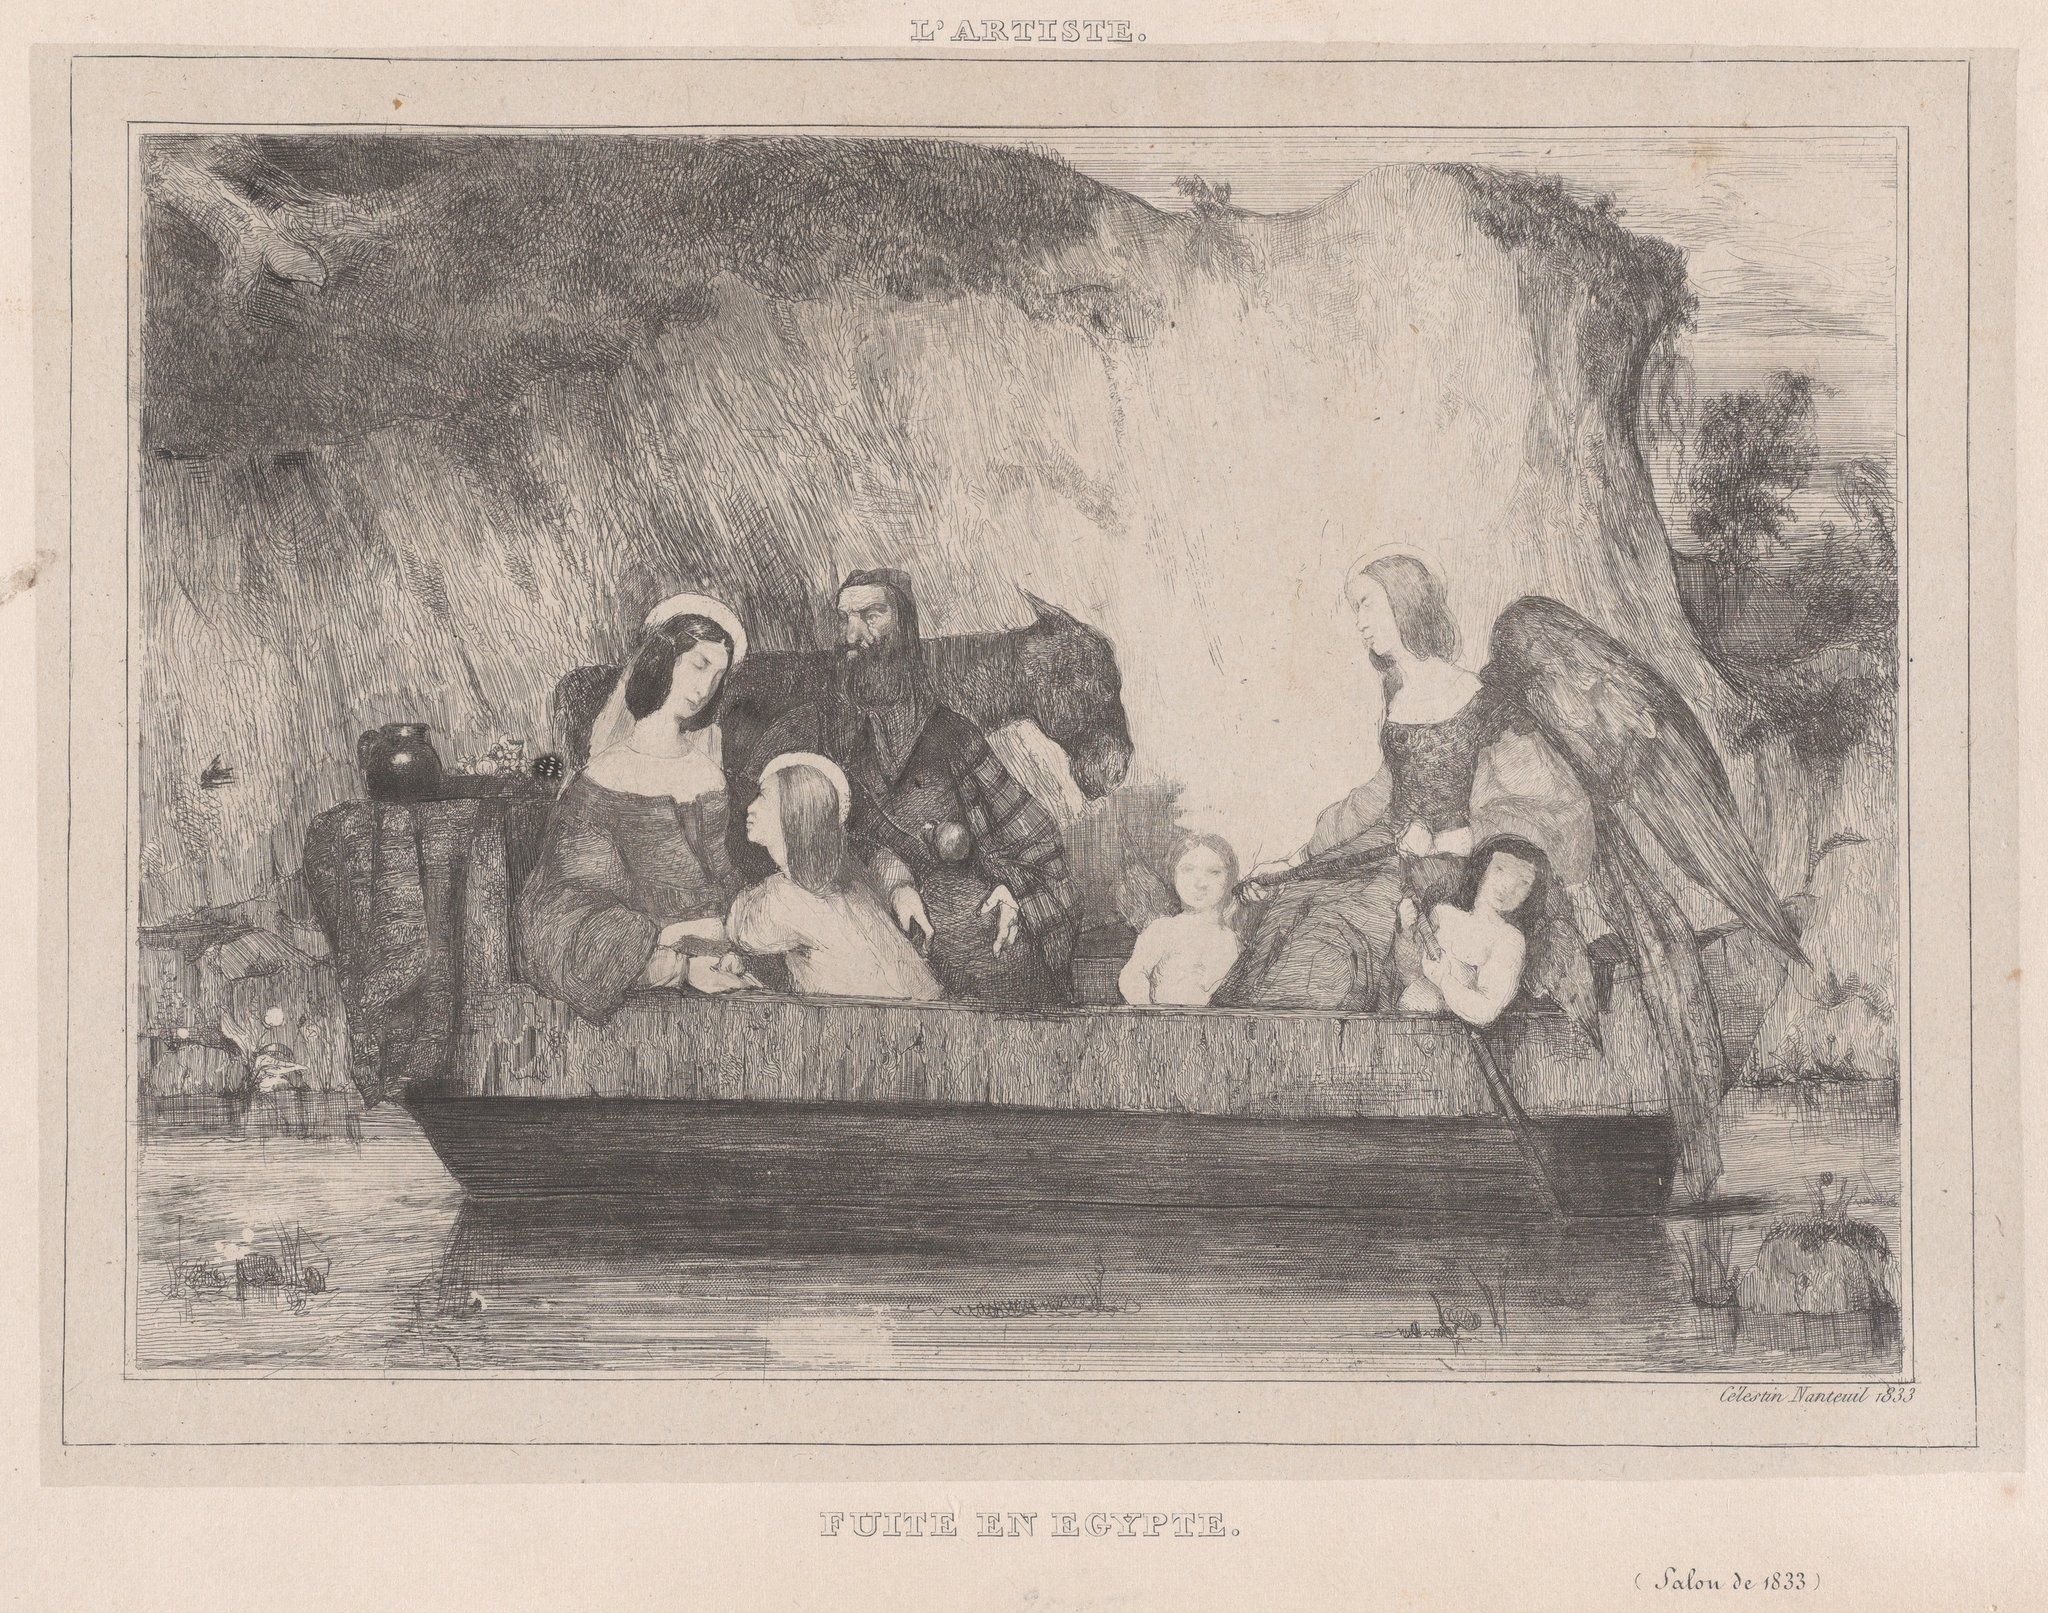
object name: print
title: Flight from Egypt, from "L'Artiste"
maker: célestin nanteuil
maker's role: artist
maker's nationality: french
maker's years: 1813-1873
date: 1833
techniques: etching